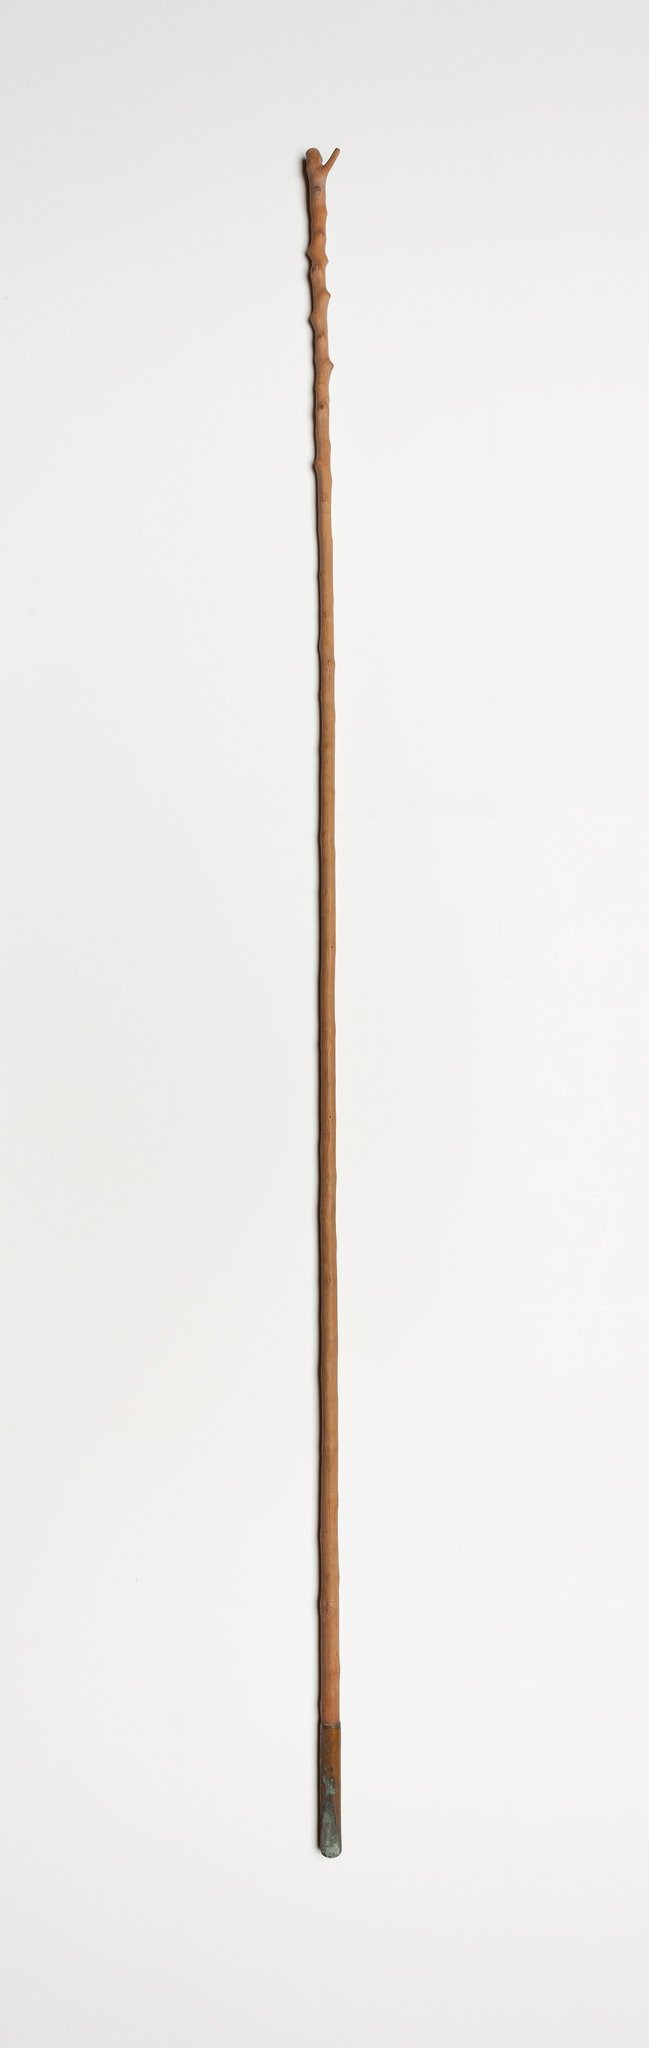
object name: staff, forked, ferrule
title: Forked Staff of Harmose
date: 1479-1458 BCE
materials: bronze, copper alloy, wood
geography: egypt